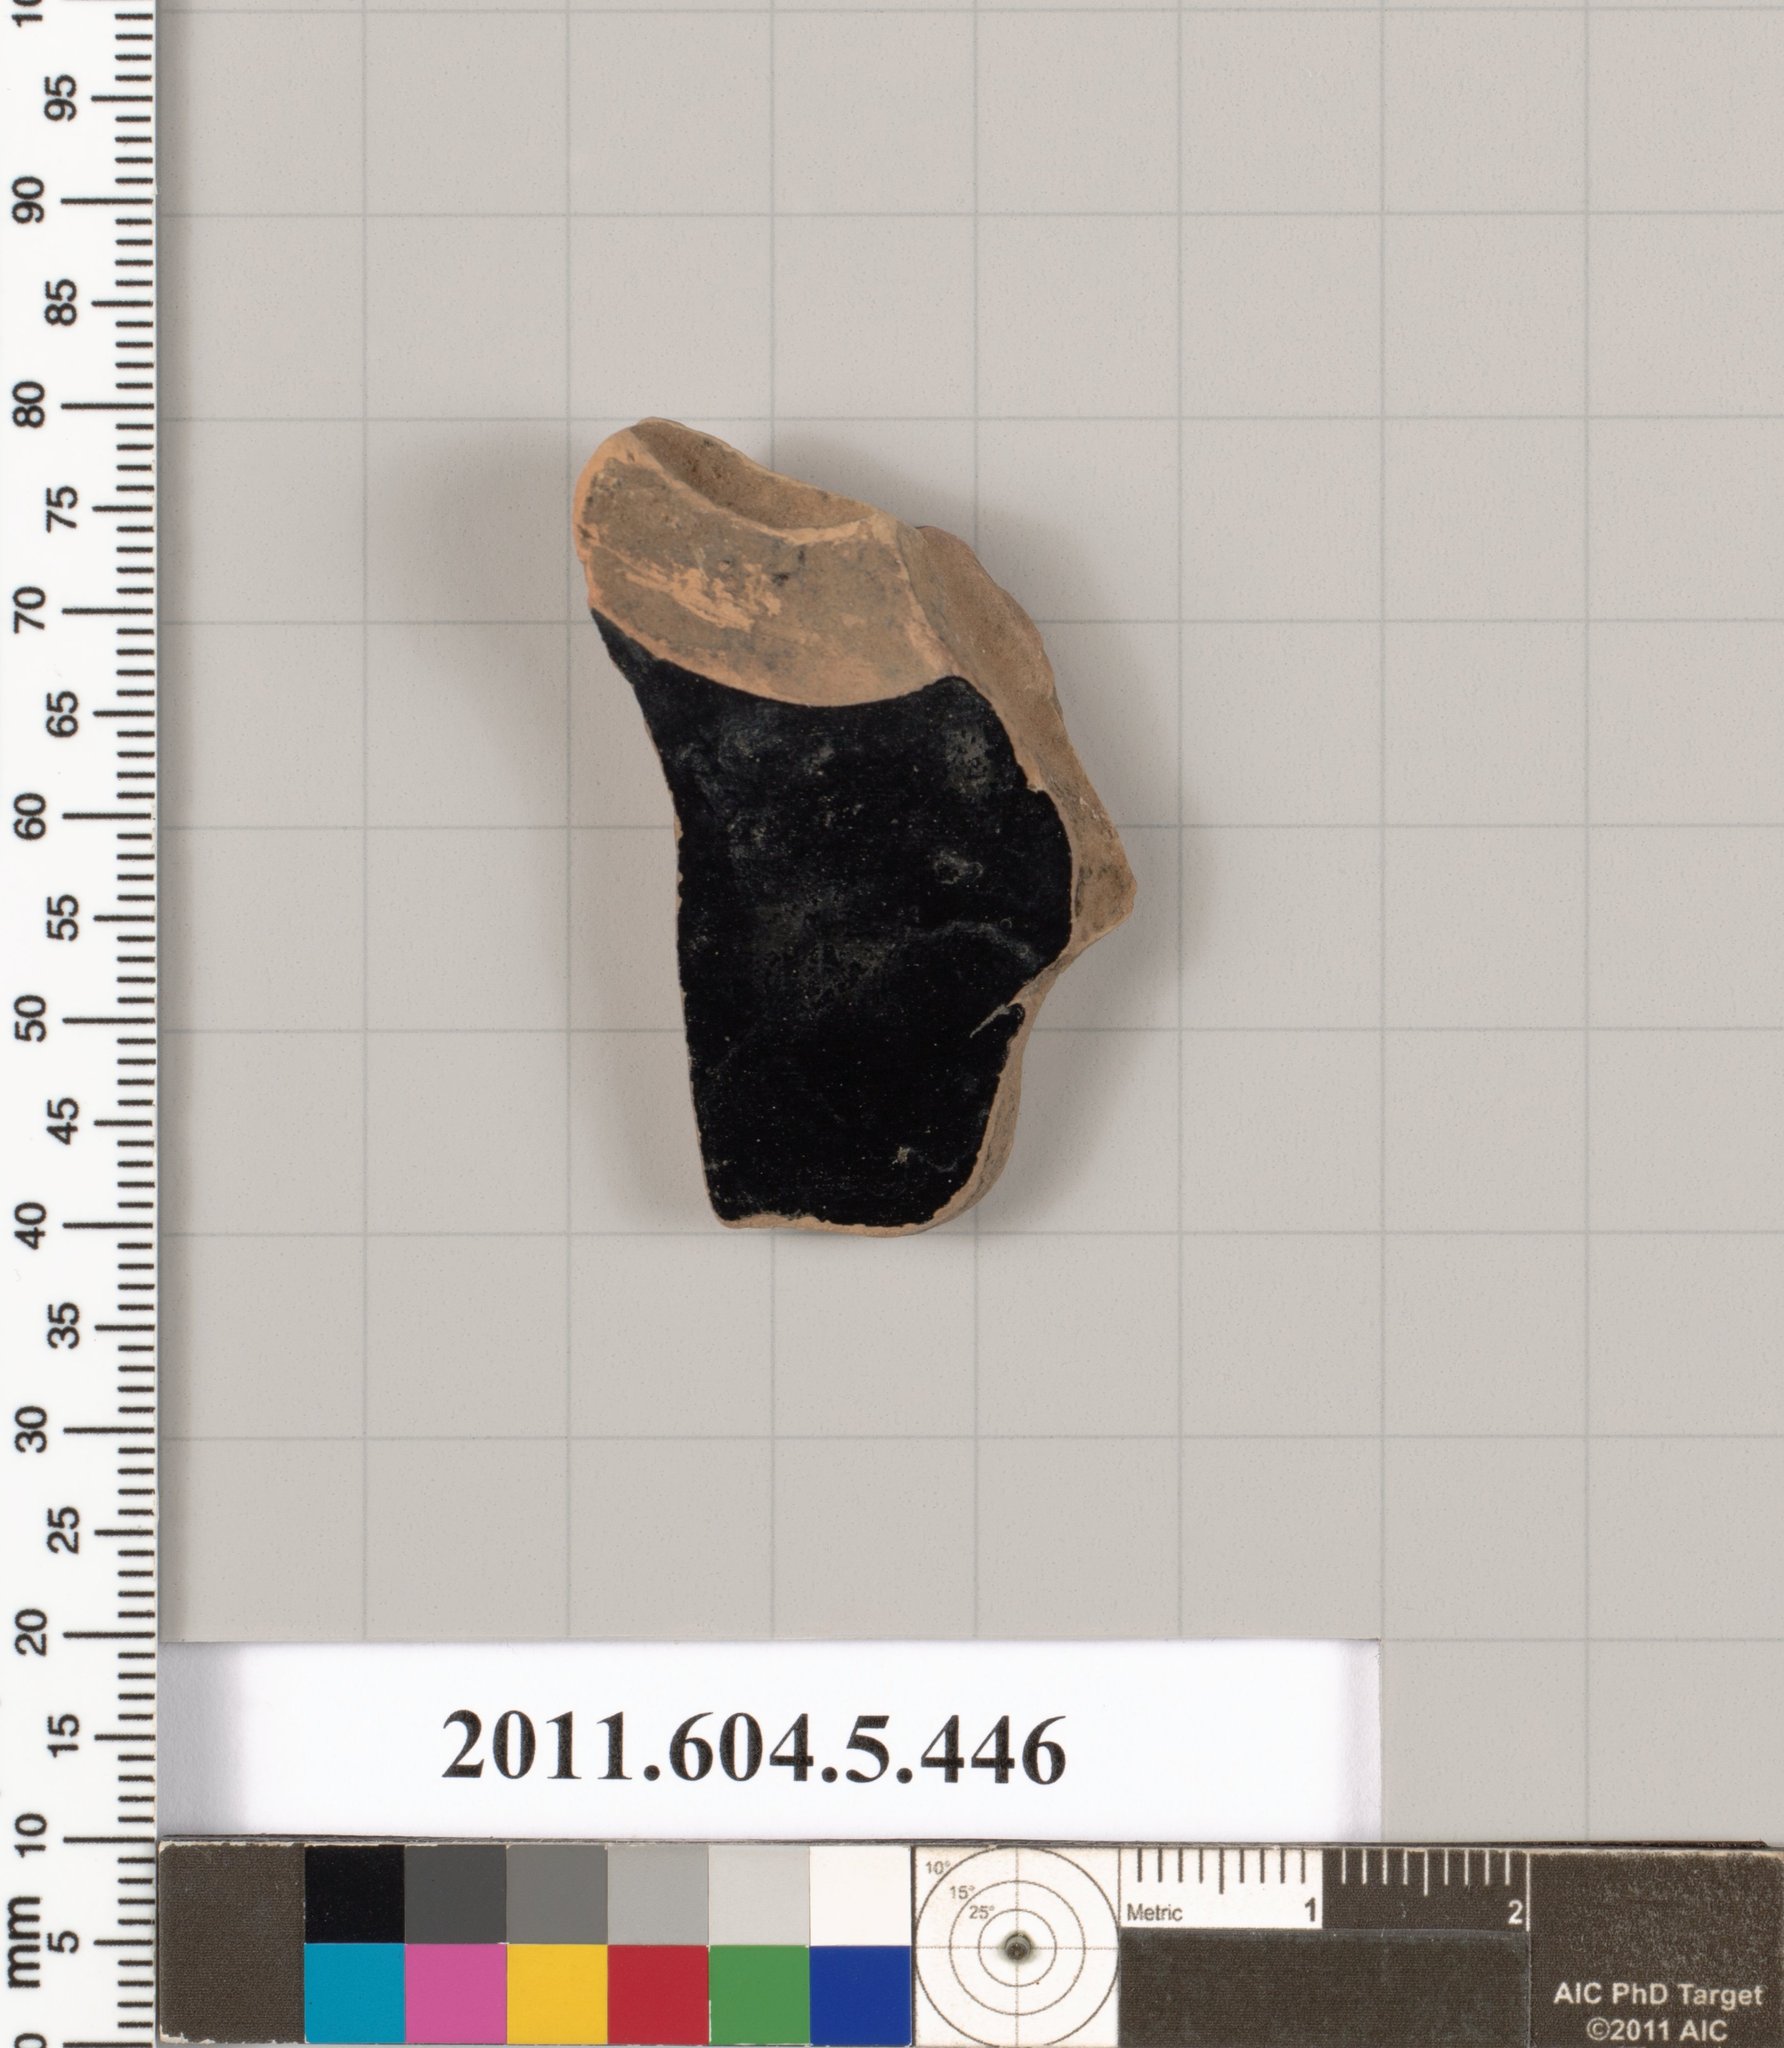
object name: kylix fragment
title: Terracotta fragment of a kylix (drinking cup)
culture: greek, attic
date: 600-401 BCE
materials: terracotta